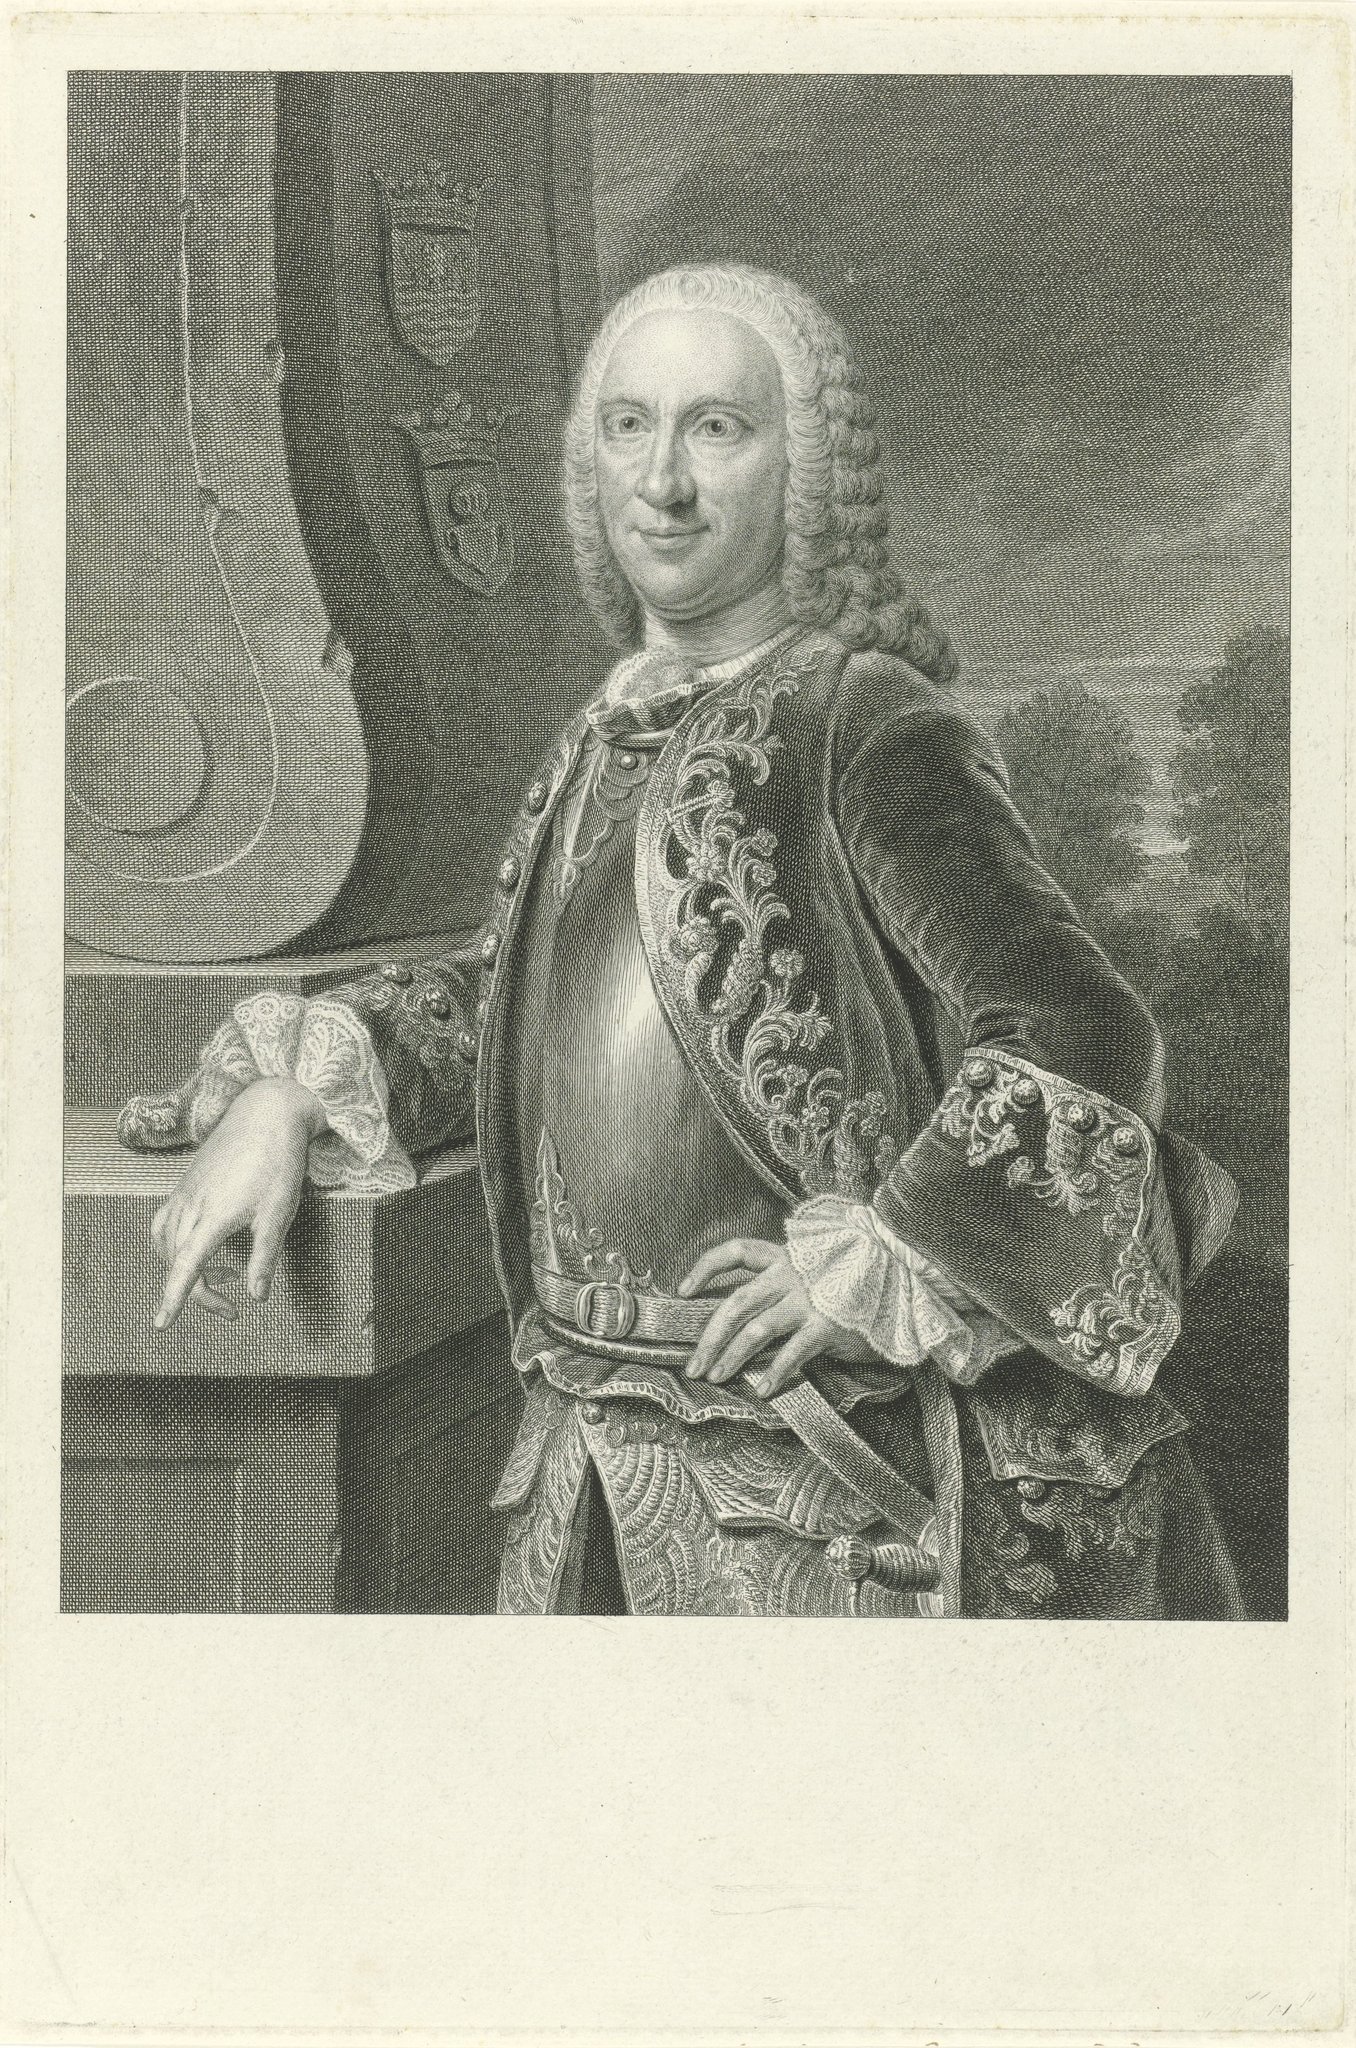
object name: print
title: Portret van Jan van Borssele van der Hooge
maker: pieter tanjé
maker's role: draughtsman, print maker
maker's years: 1706-1761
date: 1754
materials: paper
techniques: engraving, etching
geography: amsterdam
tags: the hague, armour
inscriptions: collector's mark: Lugt 2228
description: Portret van Jan van Borssele van der Hooge, vertegenwoordiger van prins Willem IV in Zeeland, gekleed in harnas, staand bij een monument.